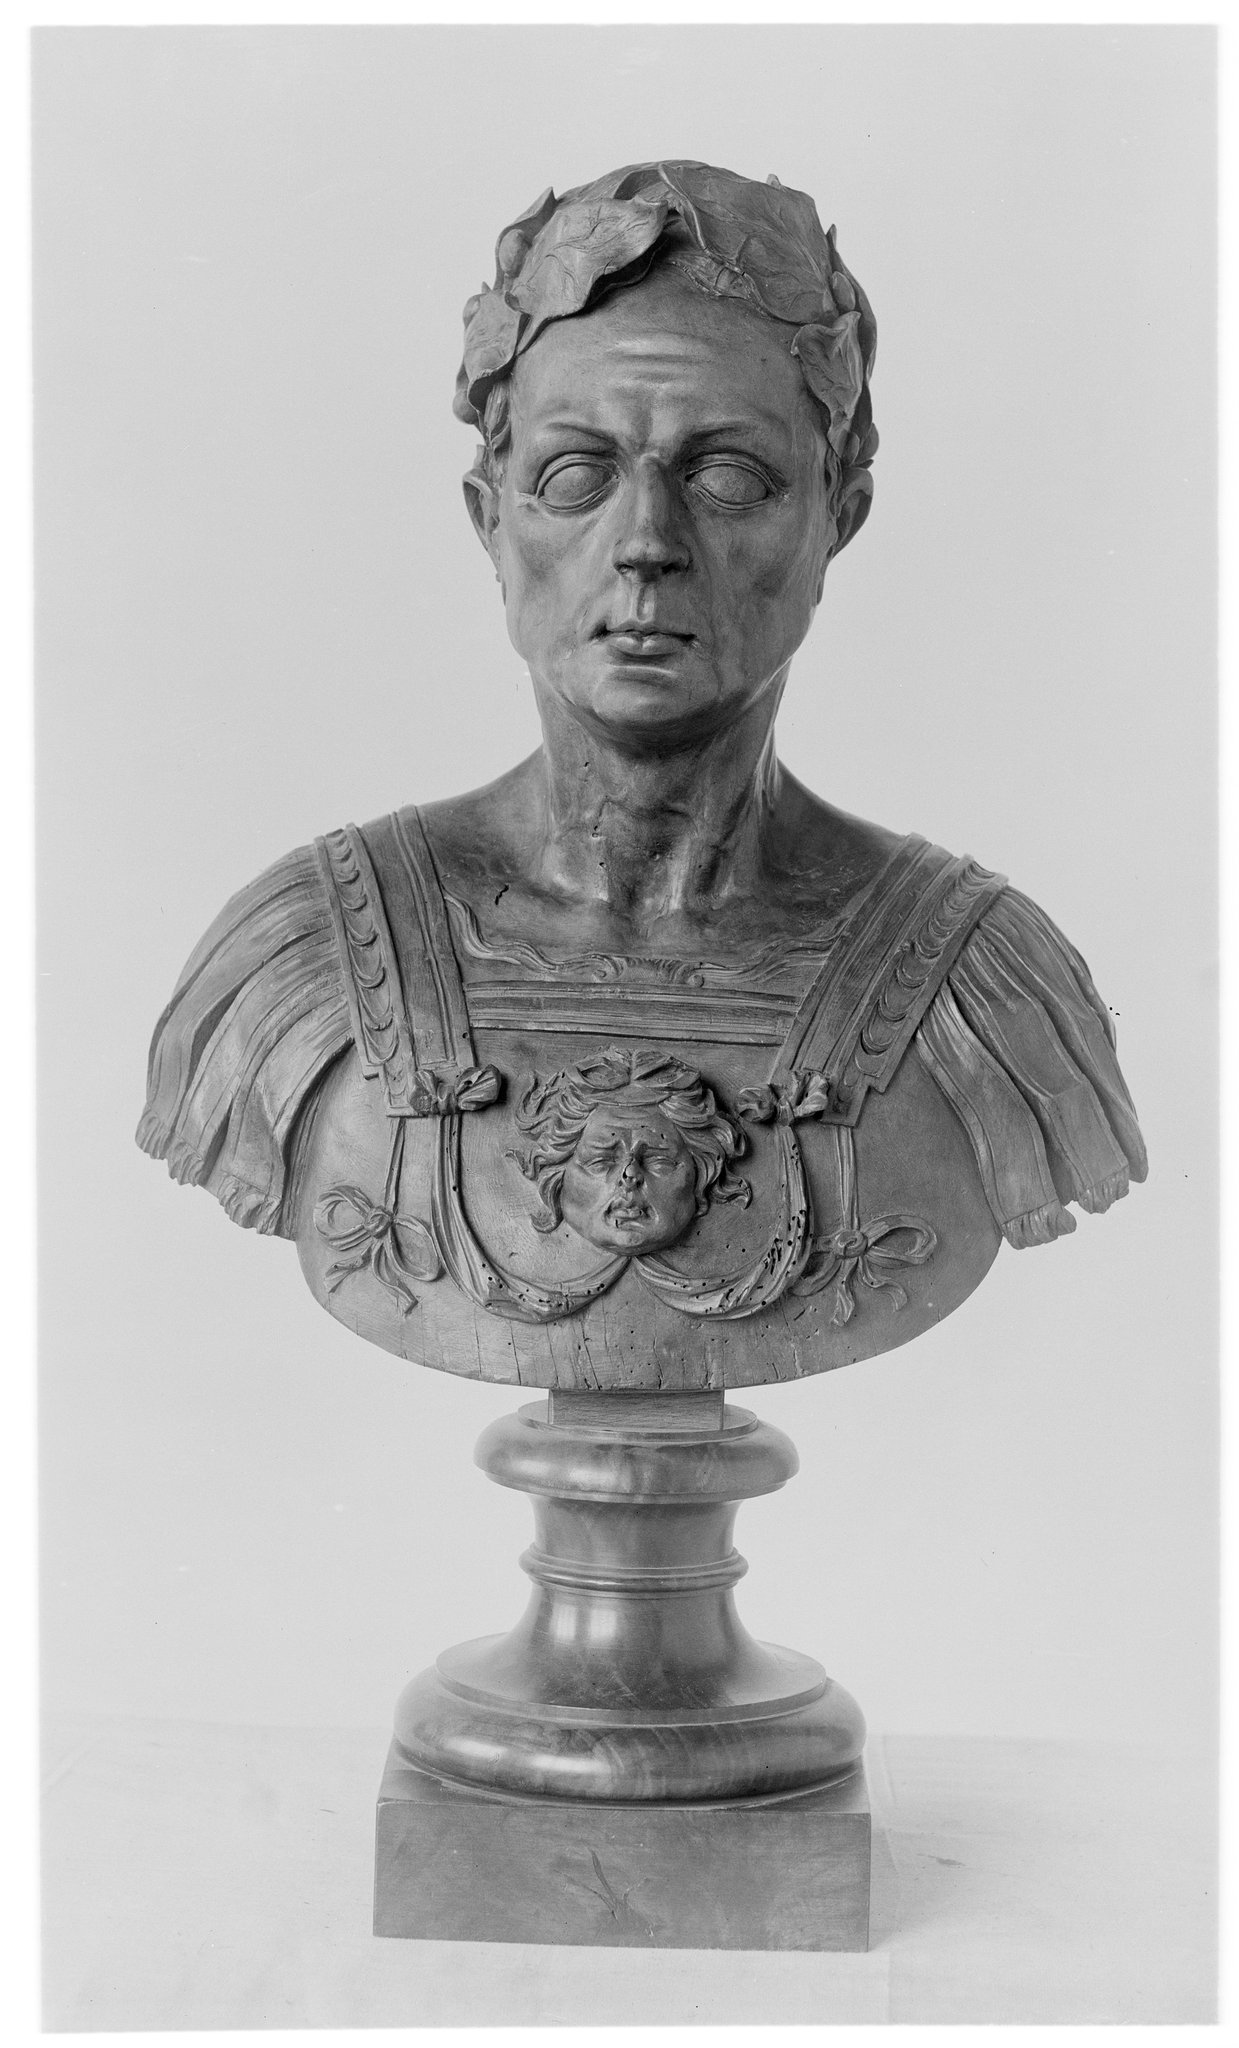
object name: bust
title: Julius Caesar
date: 1501-1700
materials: wood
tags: julius caesar,faces,portraits